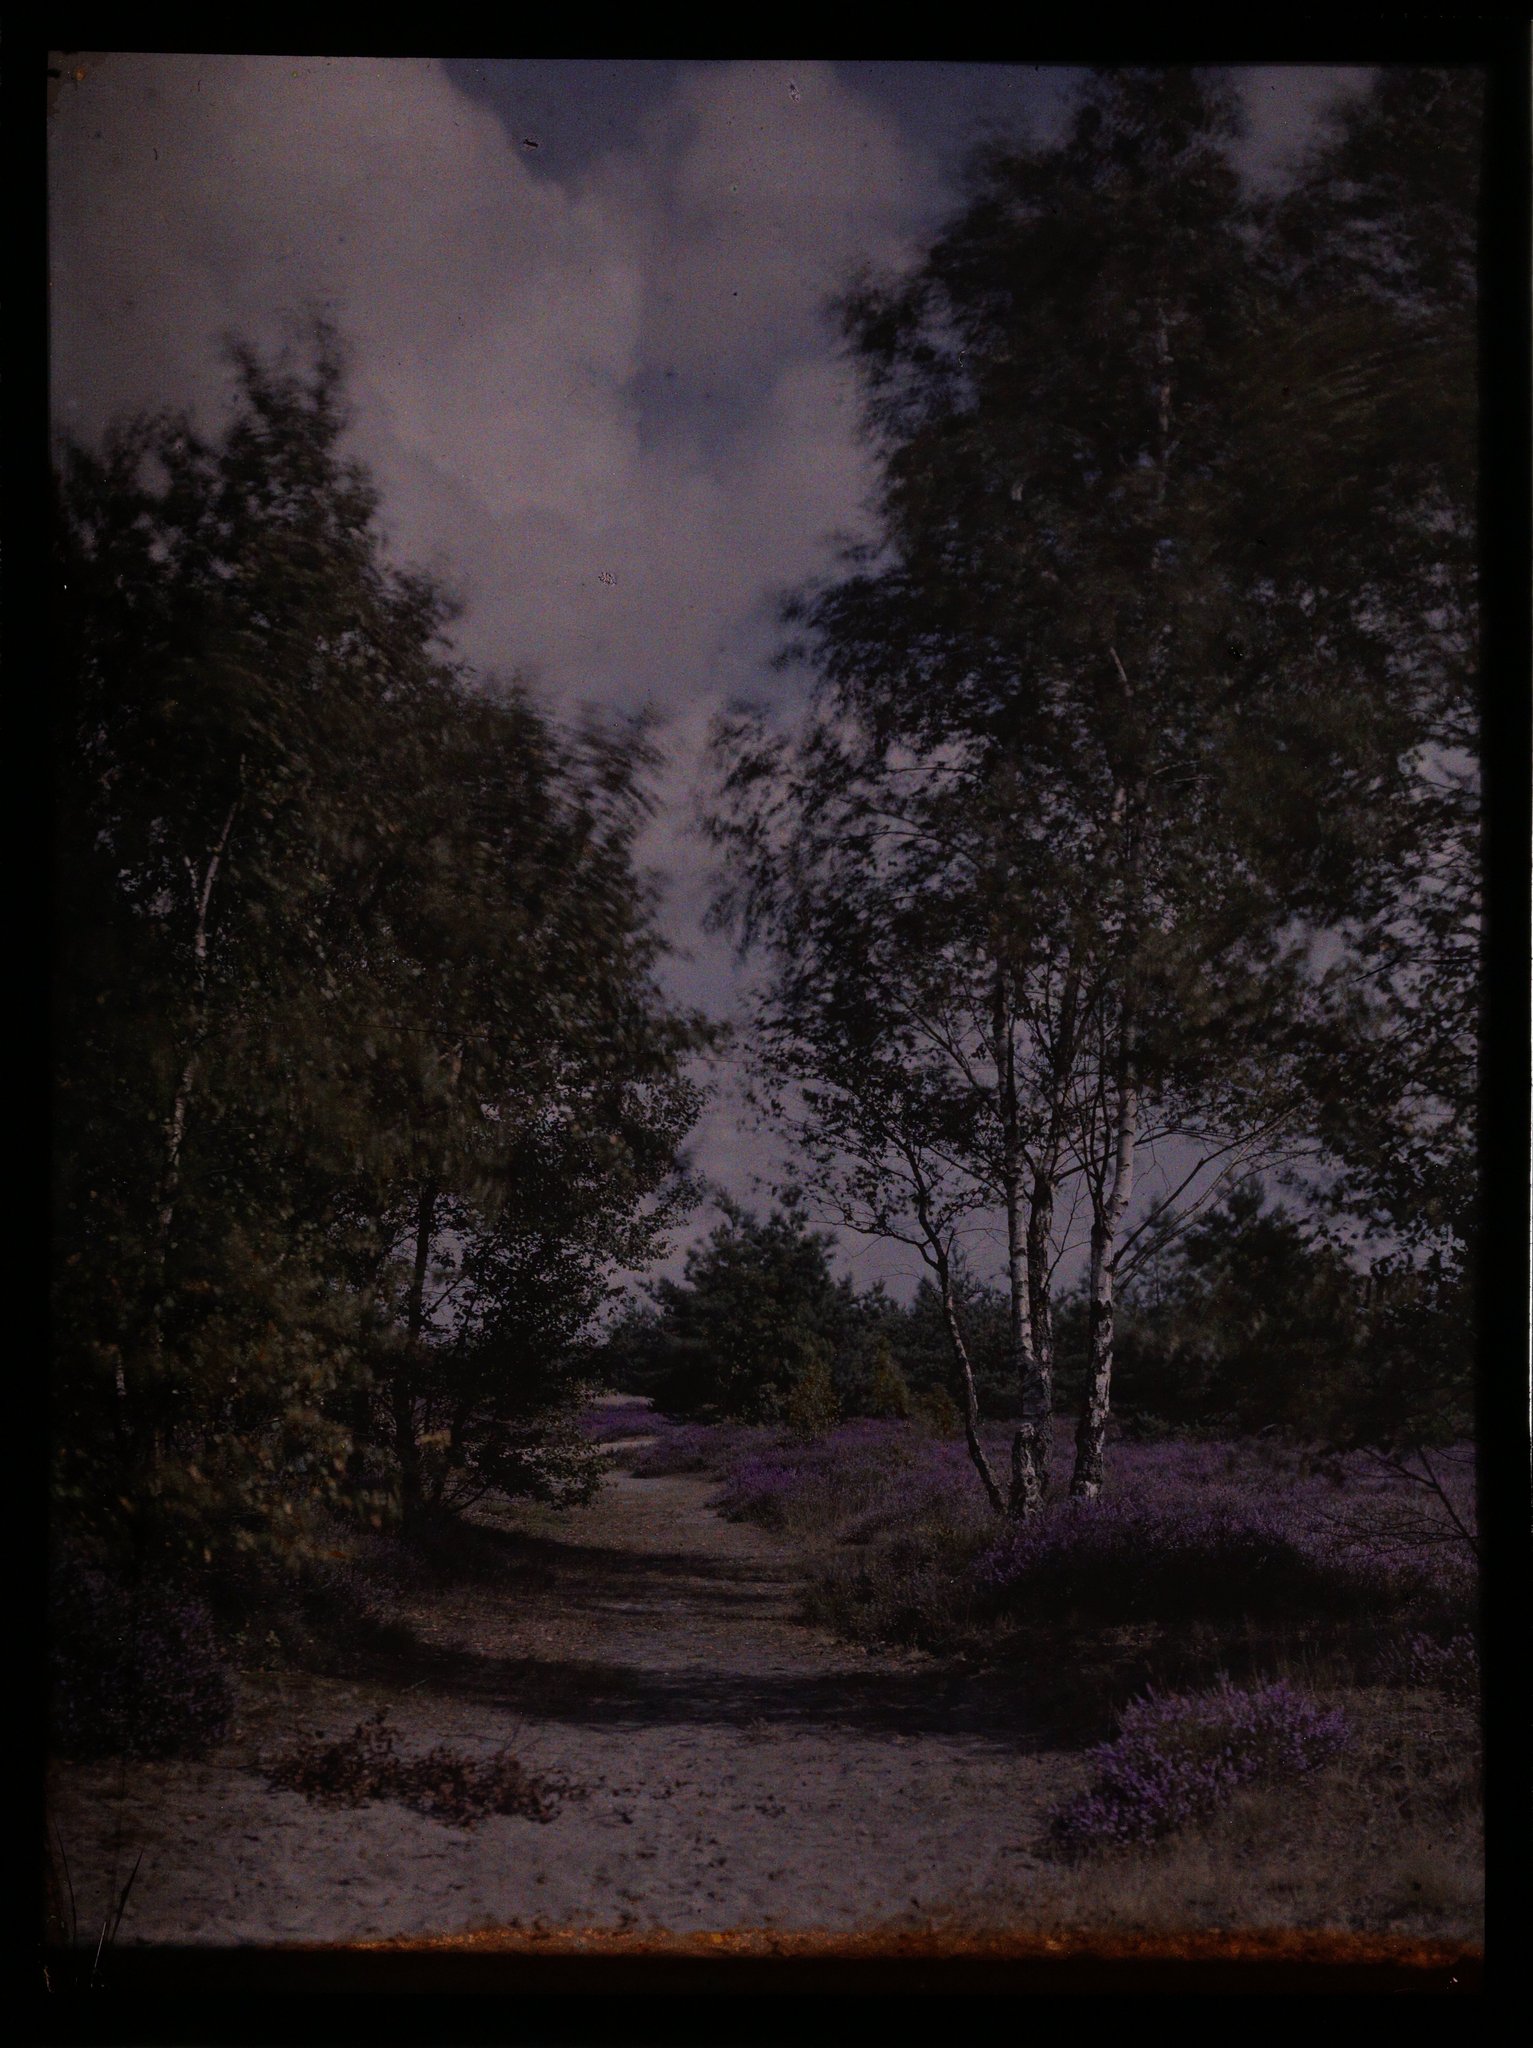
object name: photograph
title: Landschap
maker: Anonymous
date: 1907-1935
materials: glass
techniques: autochrome process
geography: netherlands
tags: netherlands